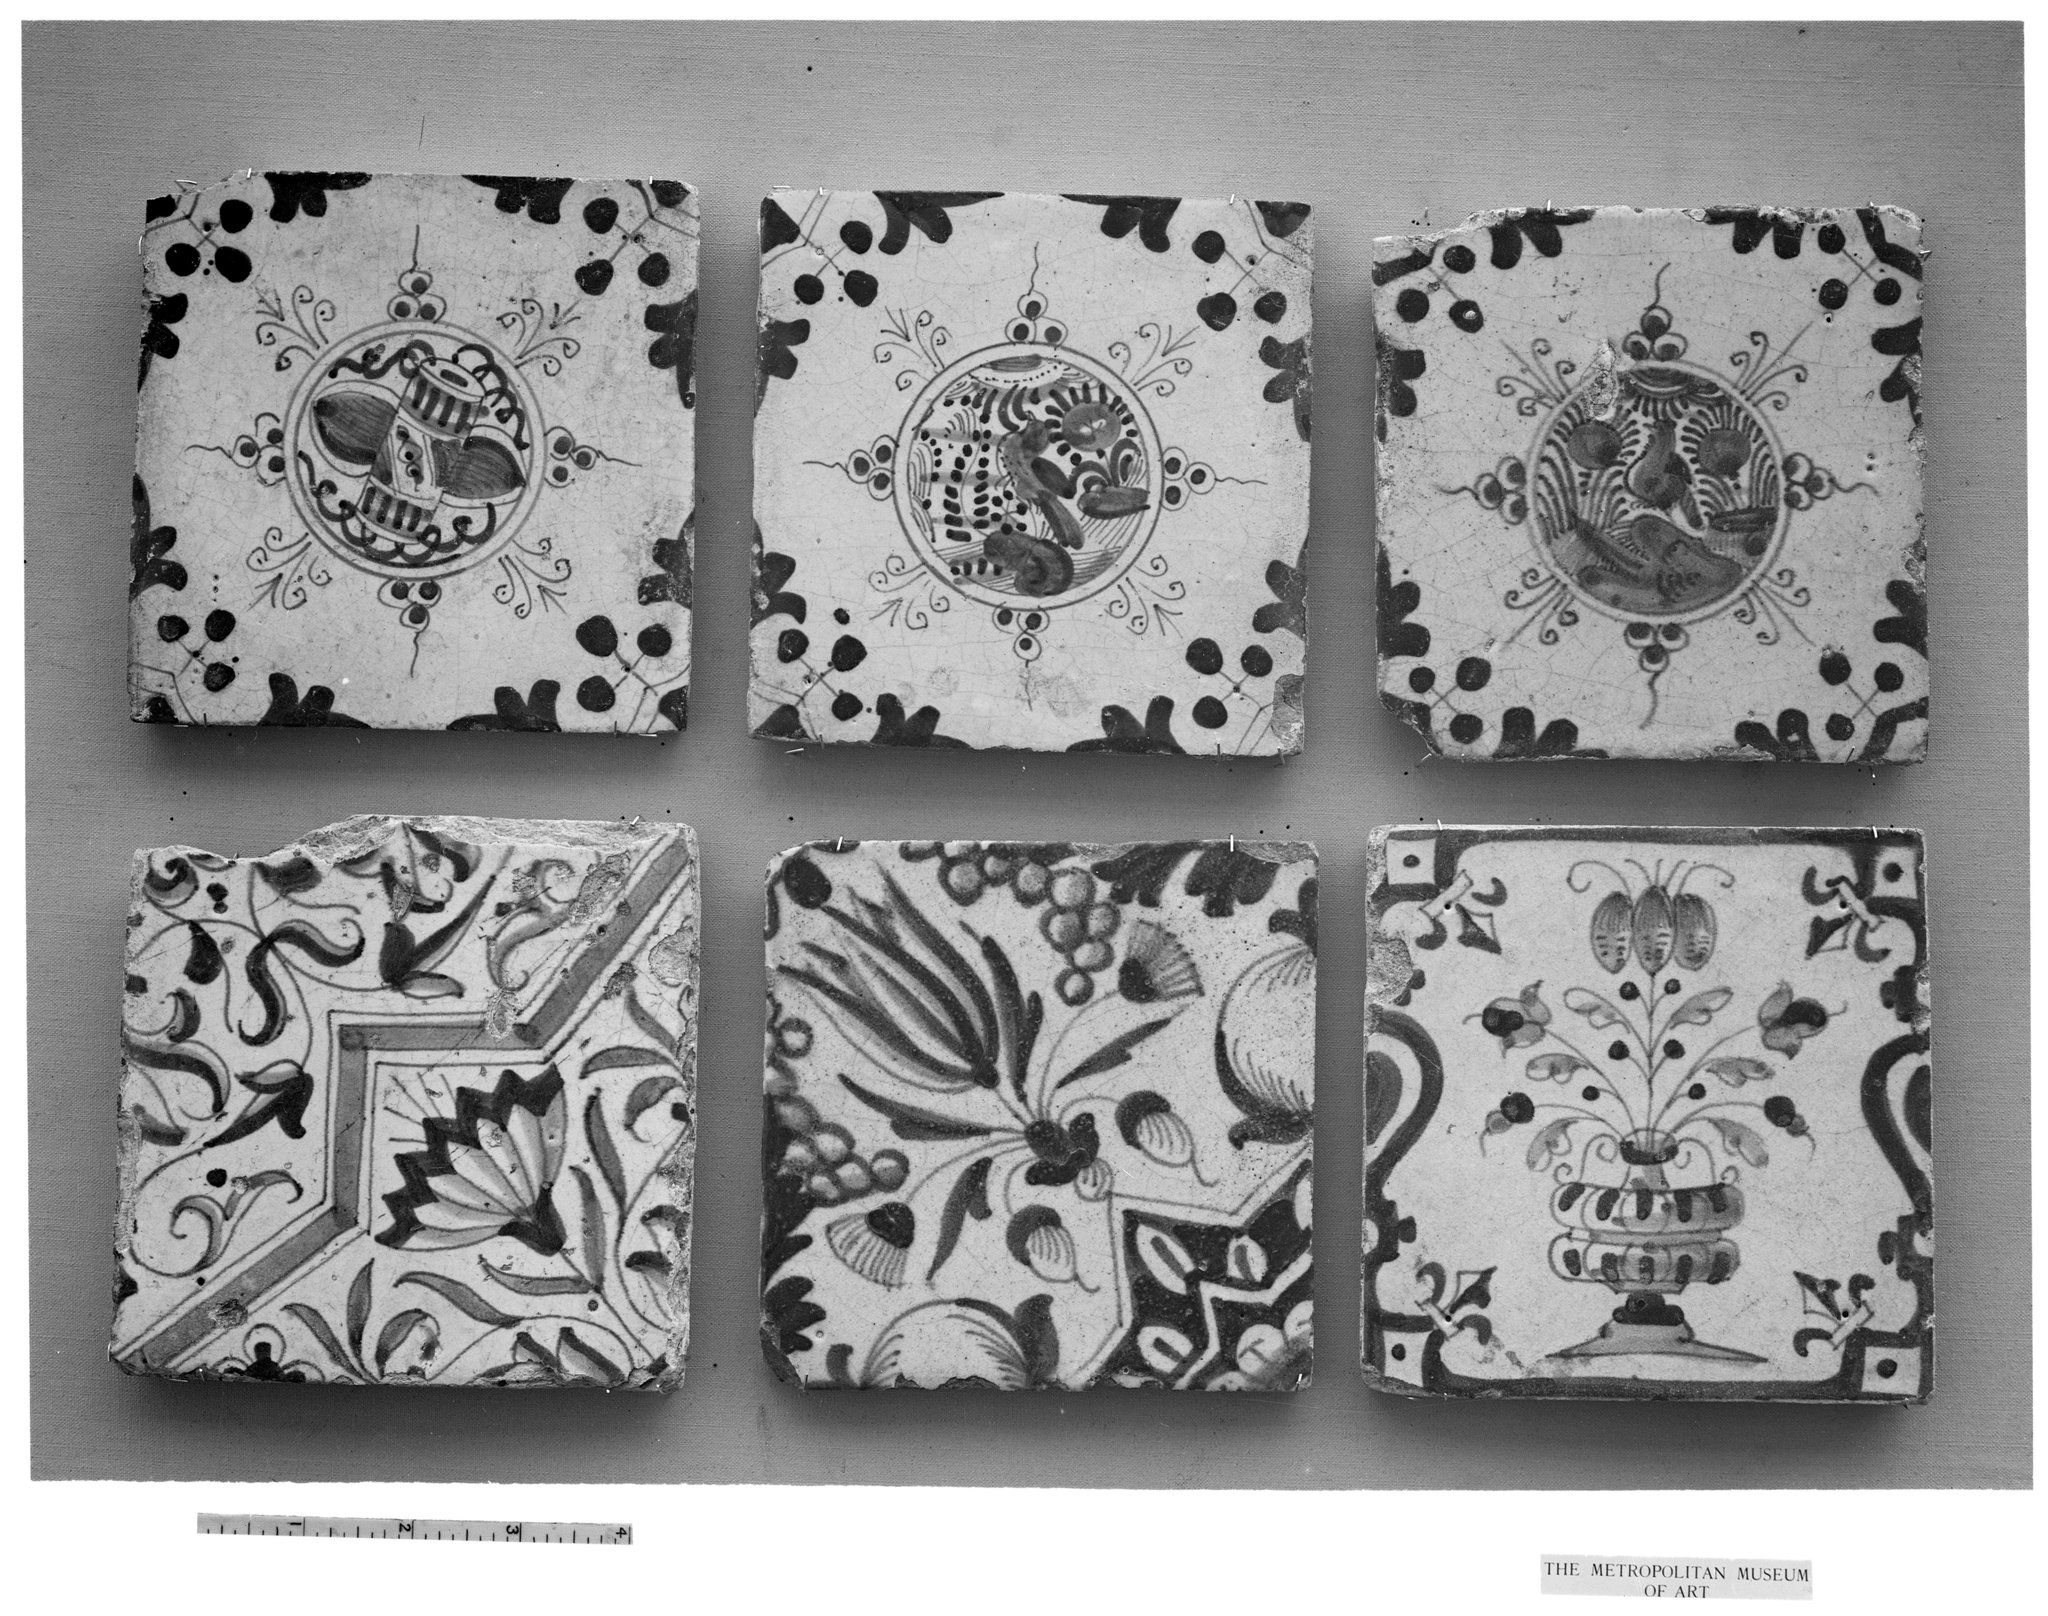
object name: tile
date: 1640-1660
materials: earthenware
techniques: glazing